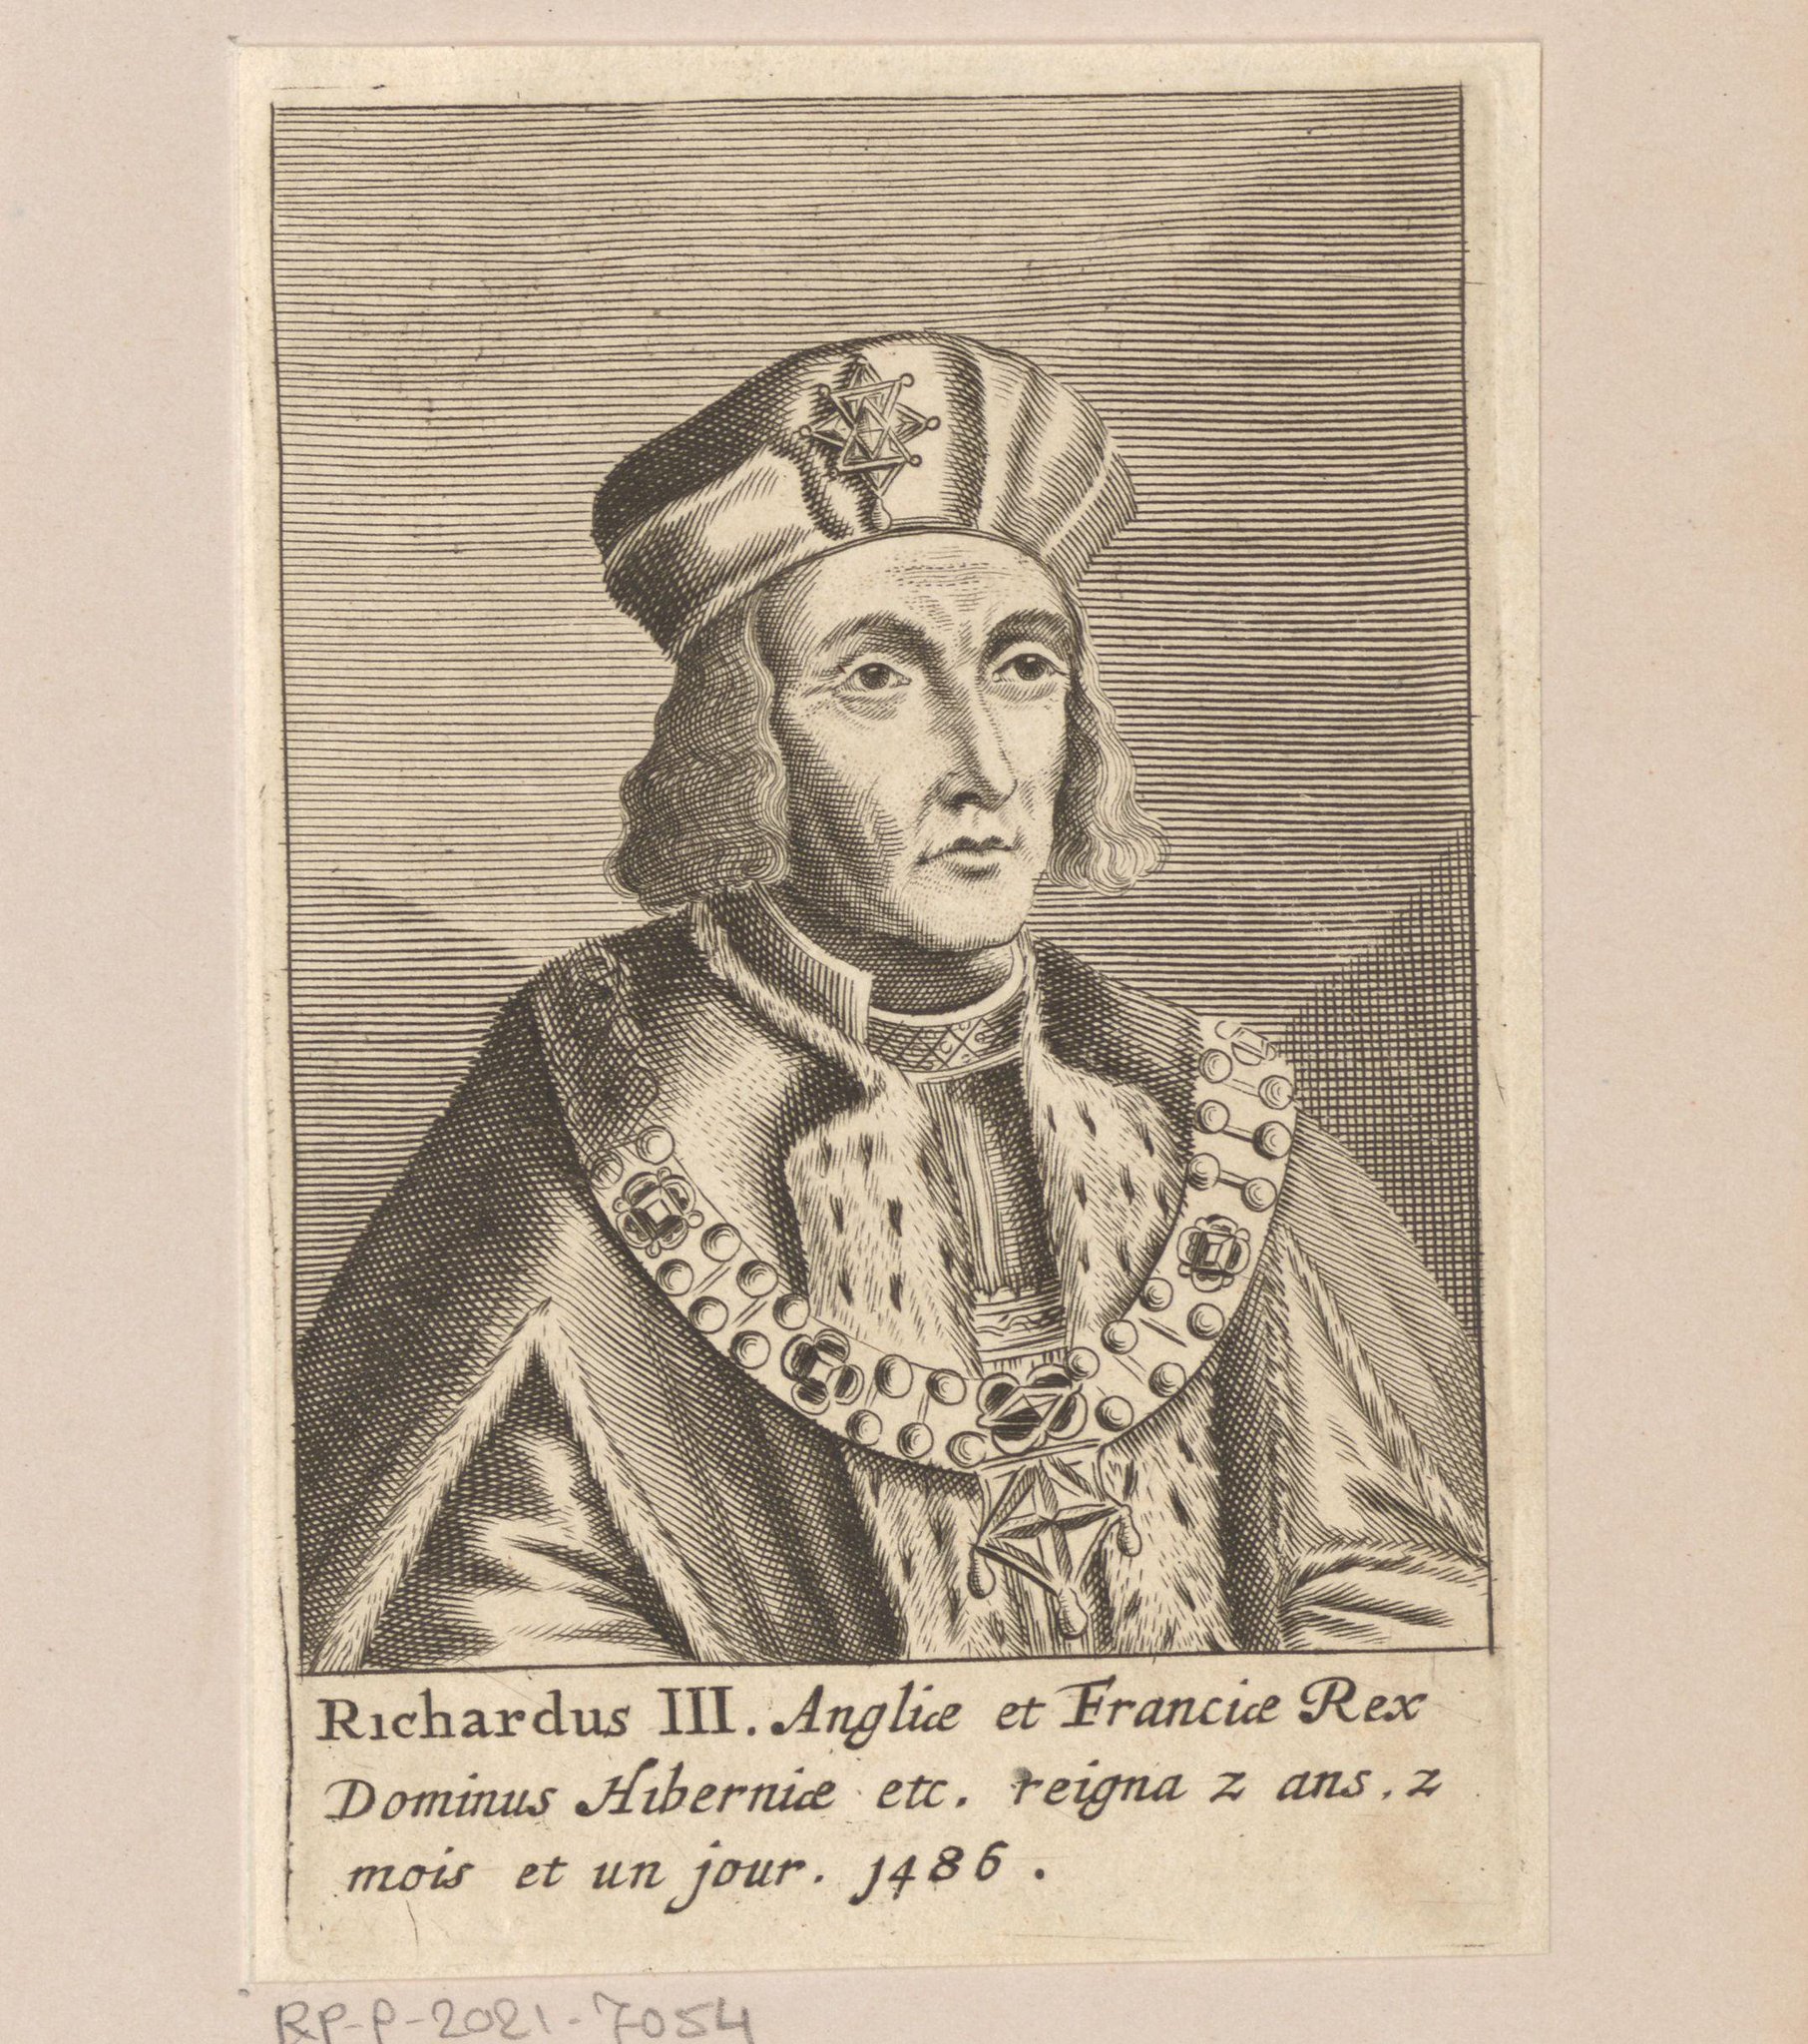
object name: print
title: Portret van Richard III, koning van Engeland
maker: Anonymous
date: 1681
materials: paper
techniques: engraving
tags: historical persons, king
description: Prent mogelijk uit: Baker, Sir Richard. Chronyck van het leven en bedrijf van al de koningen van Engelandt (...). Amsterdam: weduwe Jan Jacobsz Schipper, 1681, dl. 1.